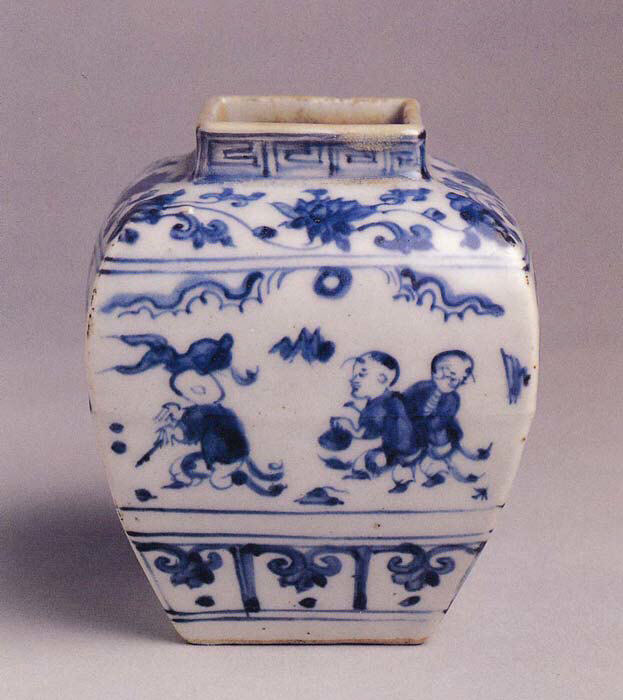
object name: jar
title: Square Jar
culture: chinese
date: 1506-1521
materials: porcelain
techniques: painting, underglaze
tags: human figures,flowers